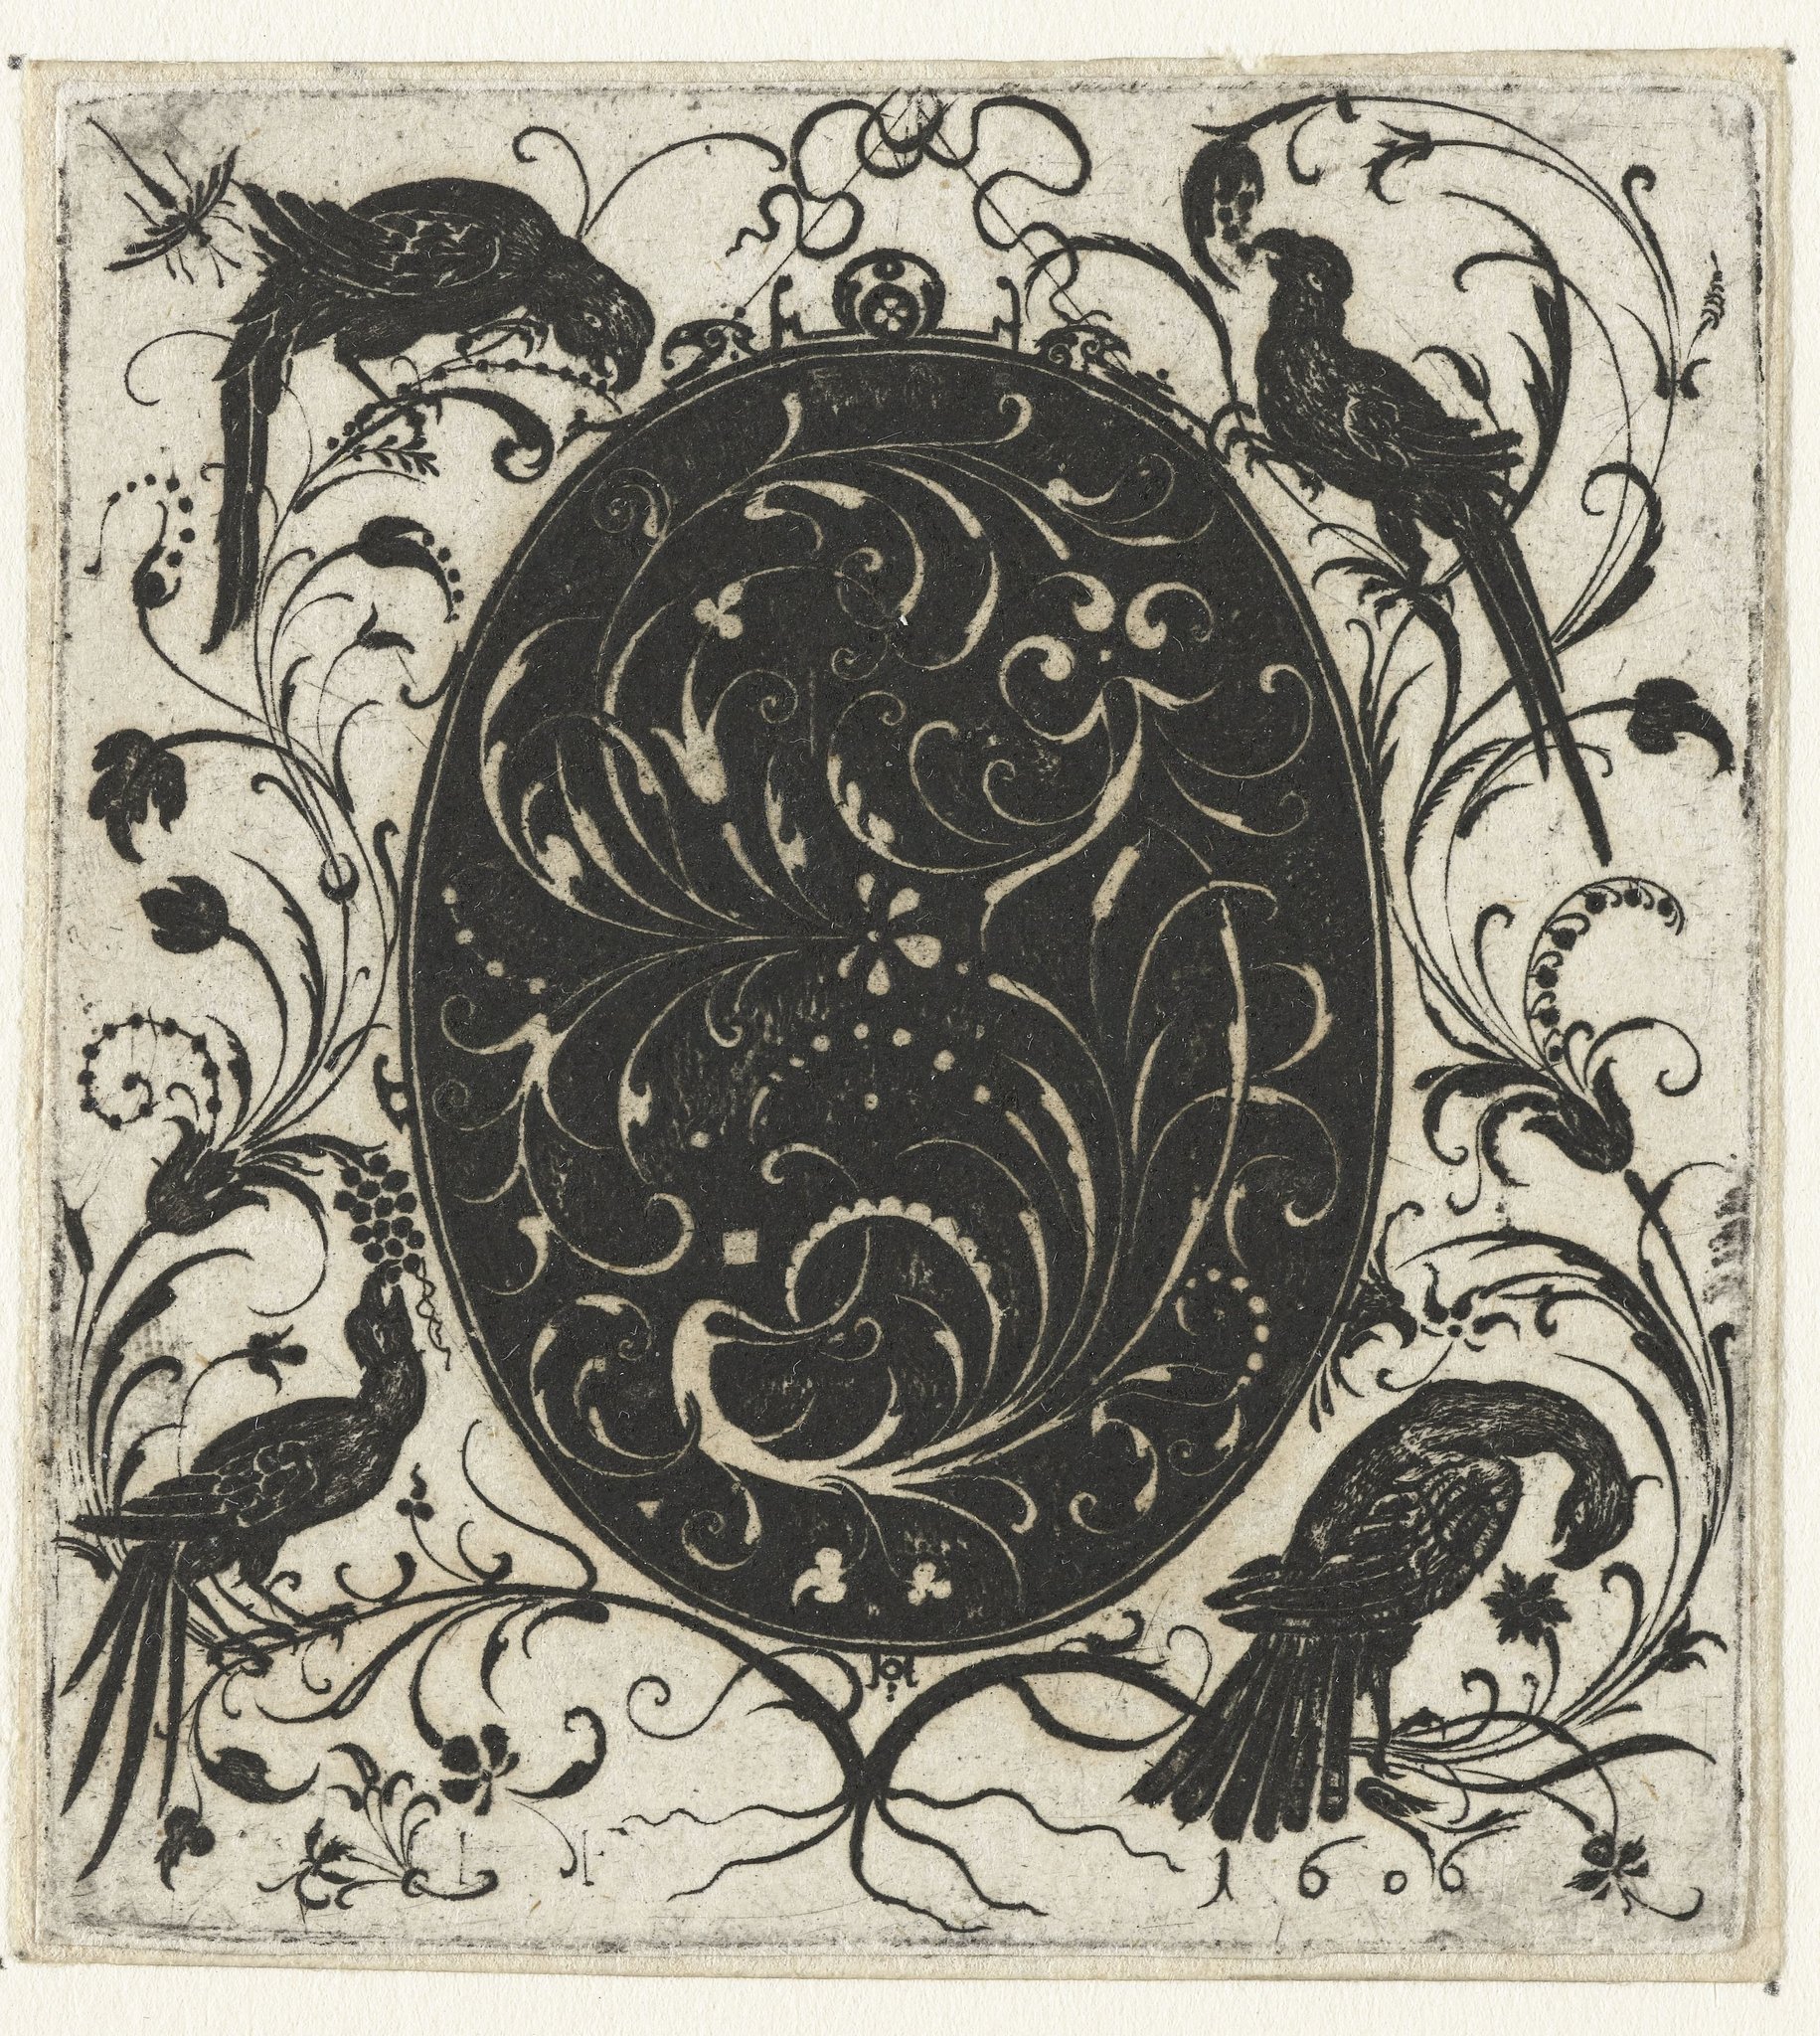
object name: ornament print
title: Ontwerpen voor goud- en zilversmeden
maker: esaias van hulsen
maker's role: engineer, goldsmith, print maker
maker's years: 1570-1626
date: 1606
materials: paper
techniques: etching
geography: stuttgart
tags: foliage ~ ornament, birds, ribbon, scroll, banderole ~ ornament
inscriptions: date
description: In elke hoek zit een vogel. Zwartornament uit serie van 6 bladen.